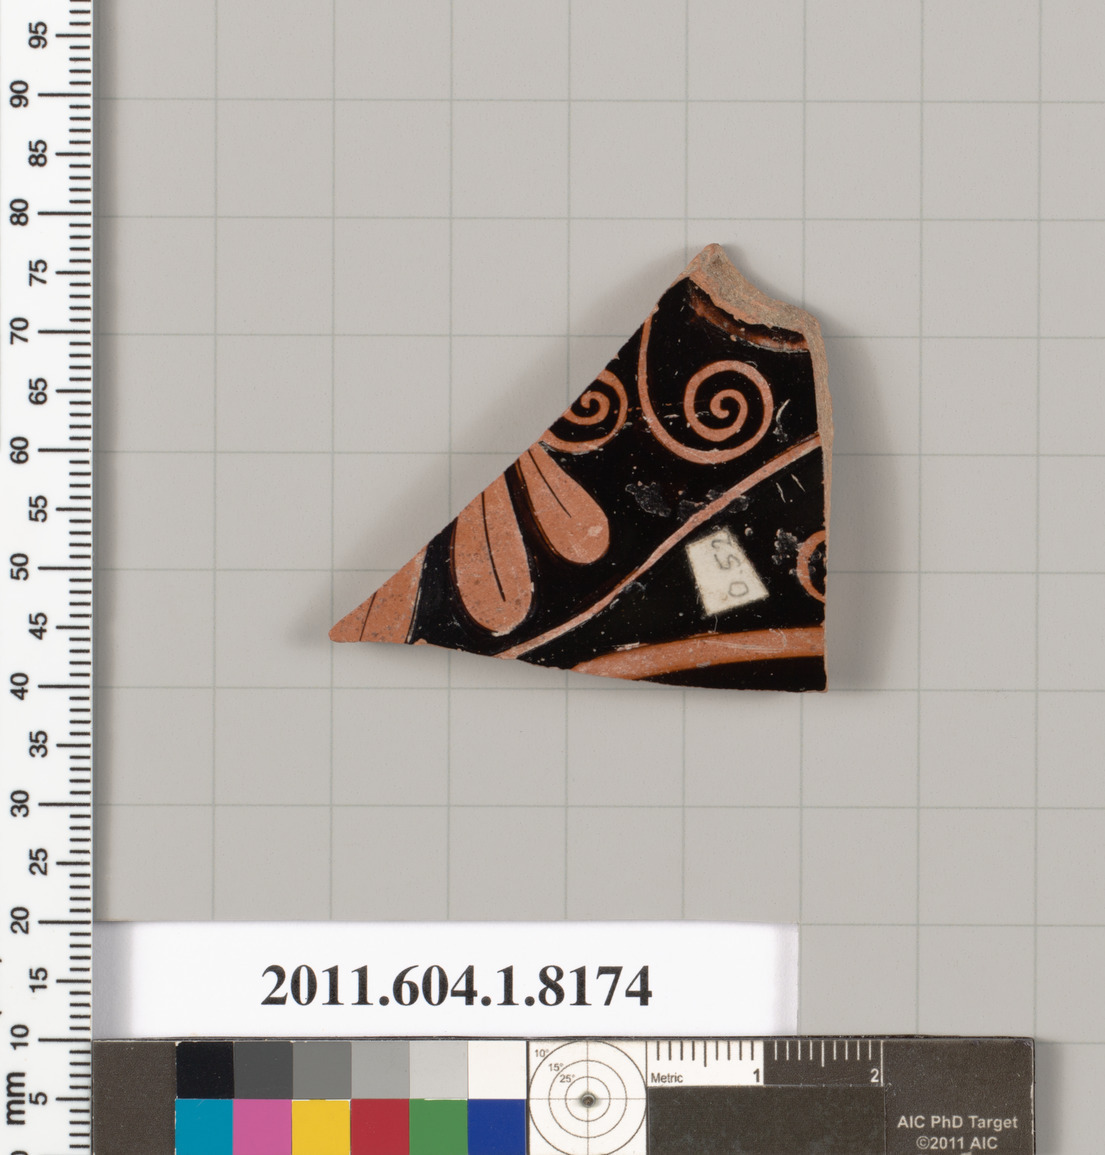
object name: kylix fragment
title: Terracotta fragment of a kylix (drinking cup)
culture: greek, attic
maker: skythes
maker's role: artist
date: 515-500 BCE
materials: terracotta